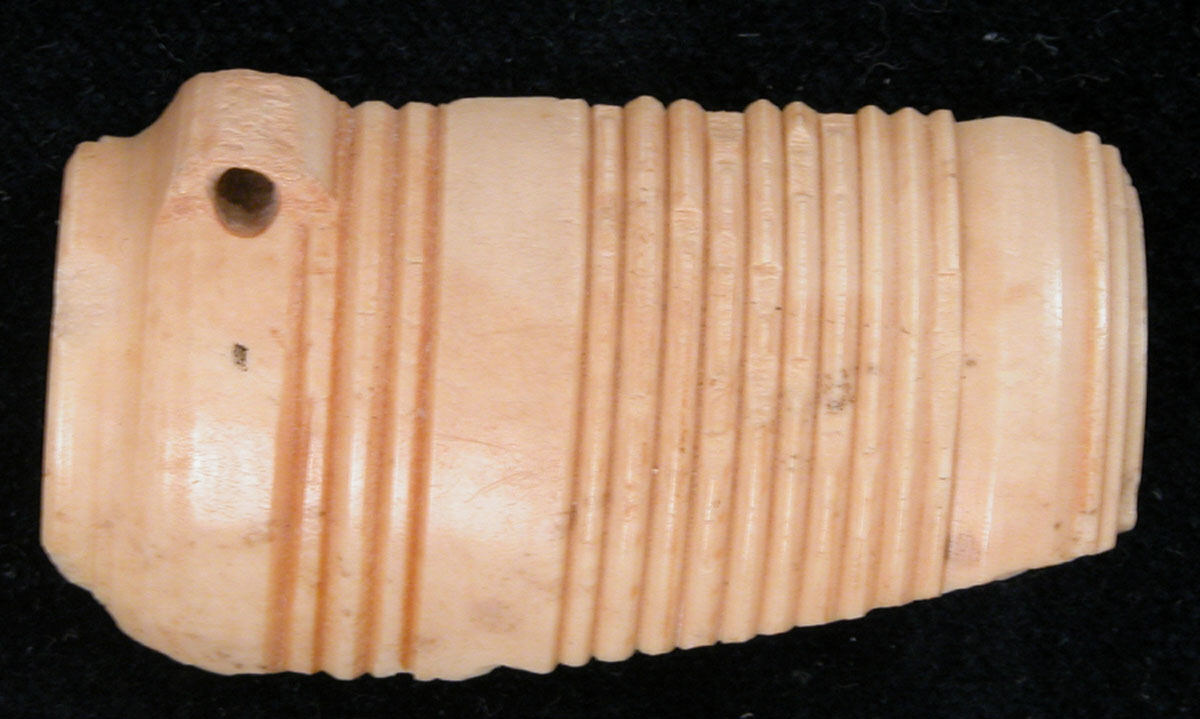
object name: fragment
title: Bone Fragment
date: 401-800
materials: bone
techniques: carving, incising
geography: palestine